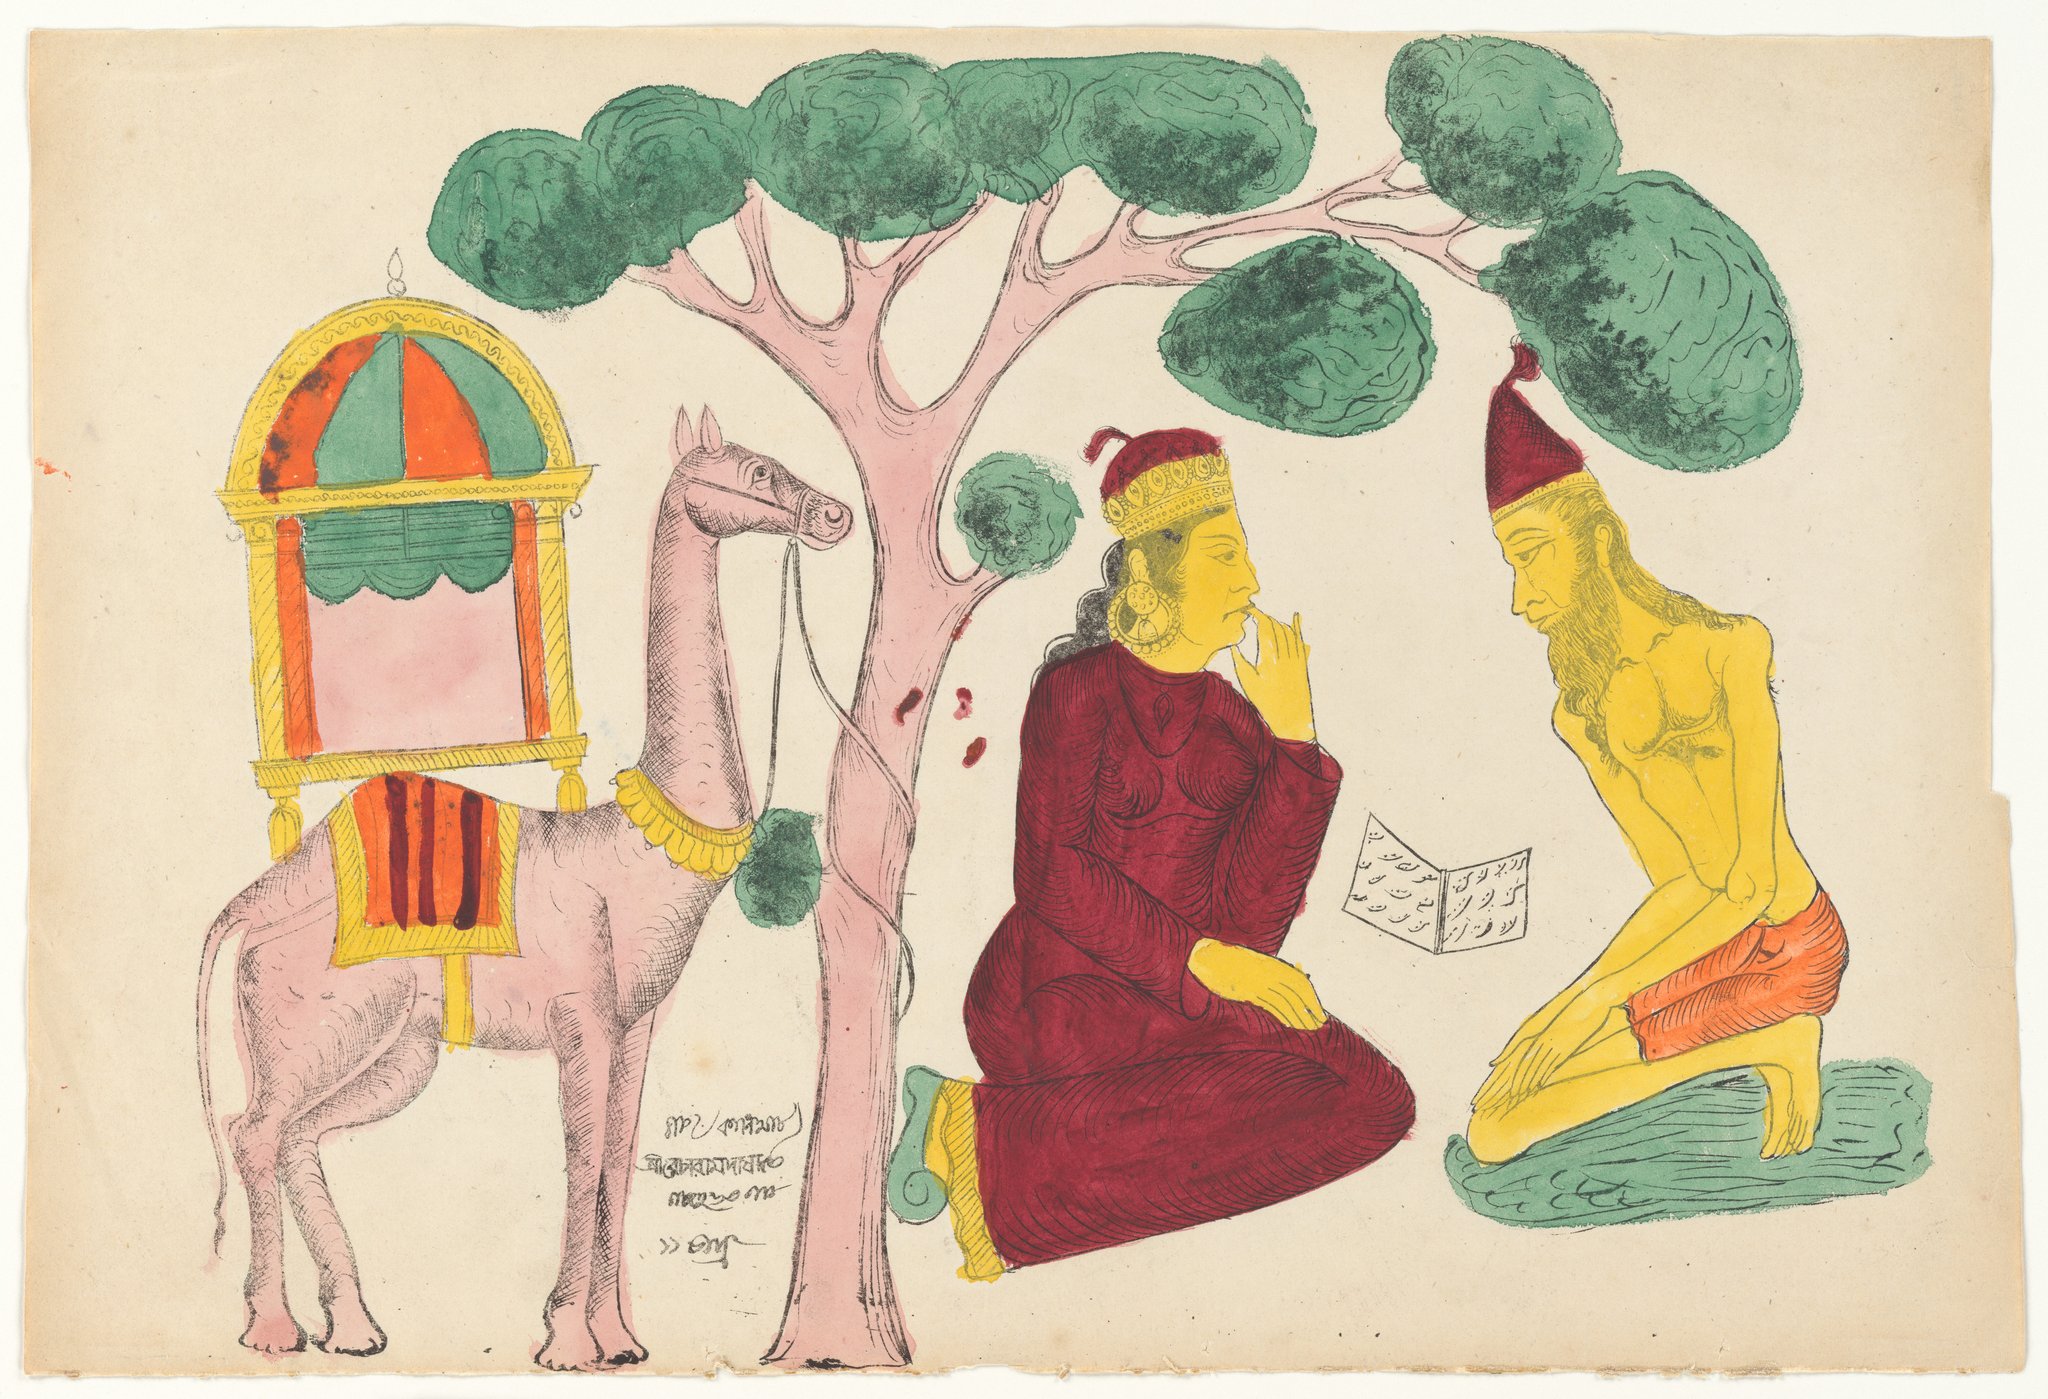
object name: print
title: Layla Visiting Majnun in the Desert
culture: indian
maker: becharam das dutta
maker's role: artist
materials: glaze, watercolor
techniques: lithograph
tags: men,women,camels,trees